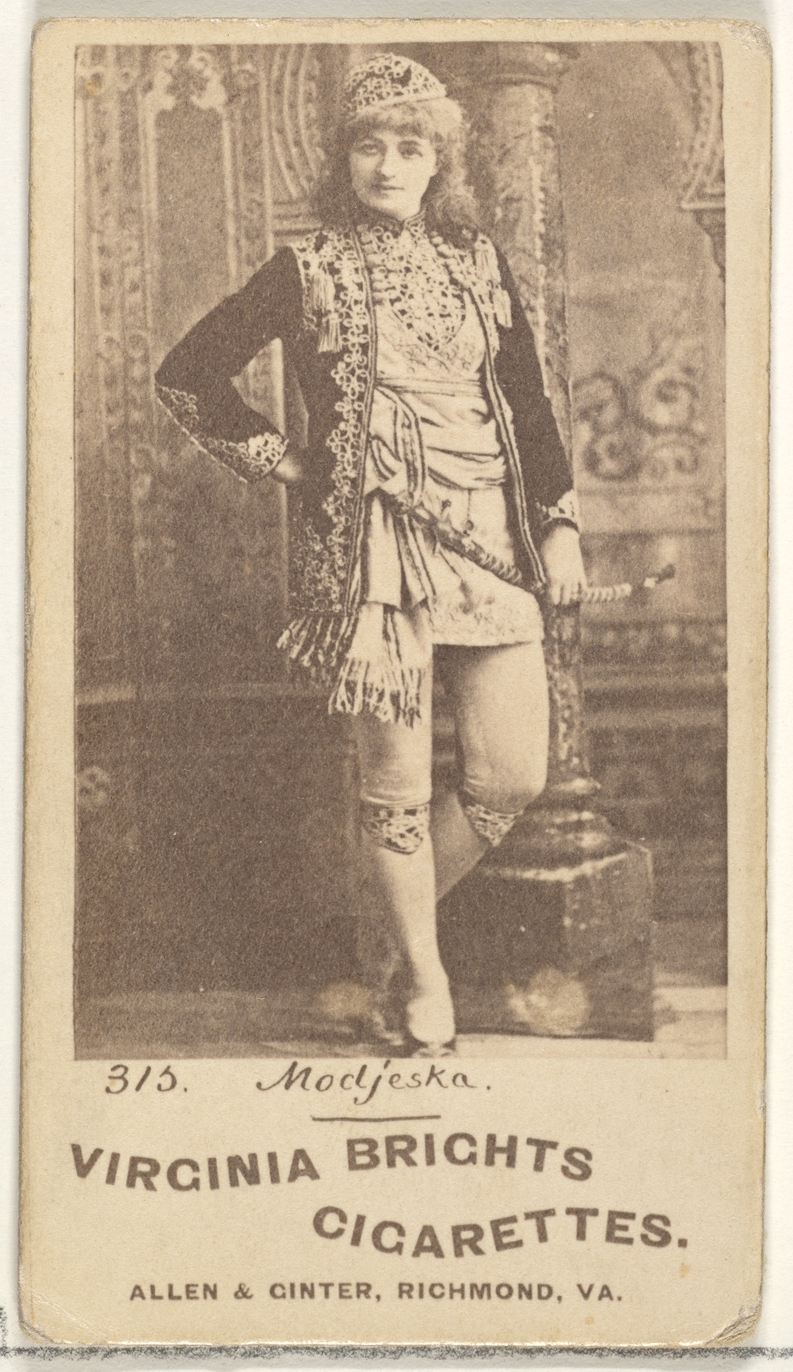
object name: photograph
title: Card 315, Modjeska, from the Actors and Actresses series (N45, Type 1) for Virginia Brights Cigarettes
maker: allen & ginter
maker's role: publisher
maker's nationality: american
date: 1888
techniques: albumen silver print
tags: portraits,women,actresses